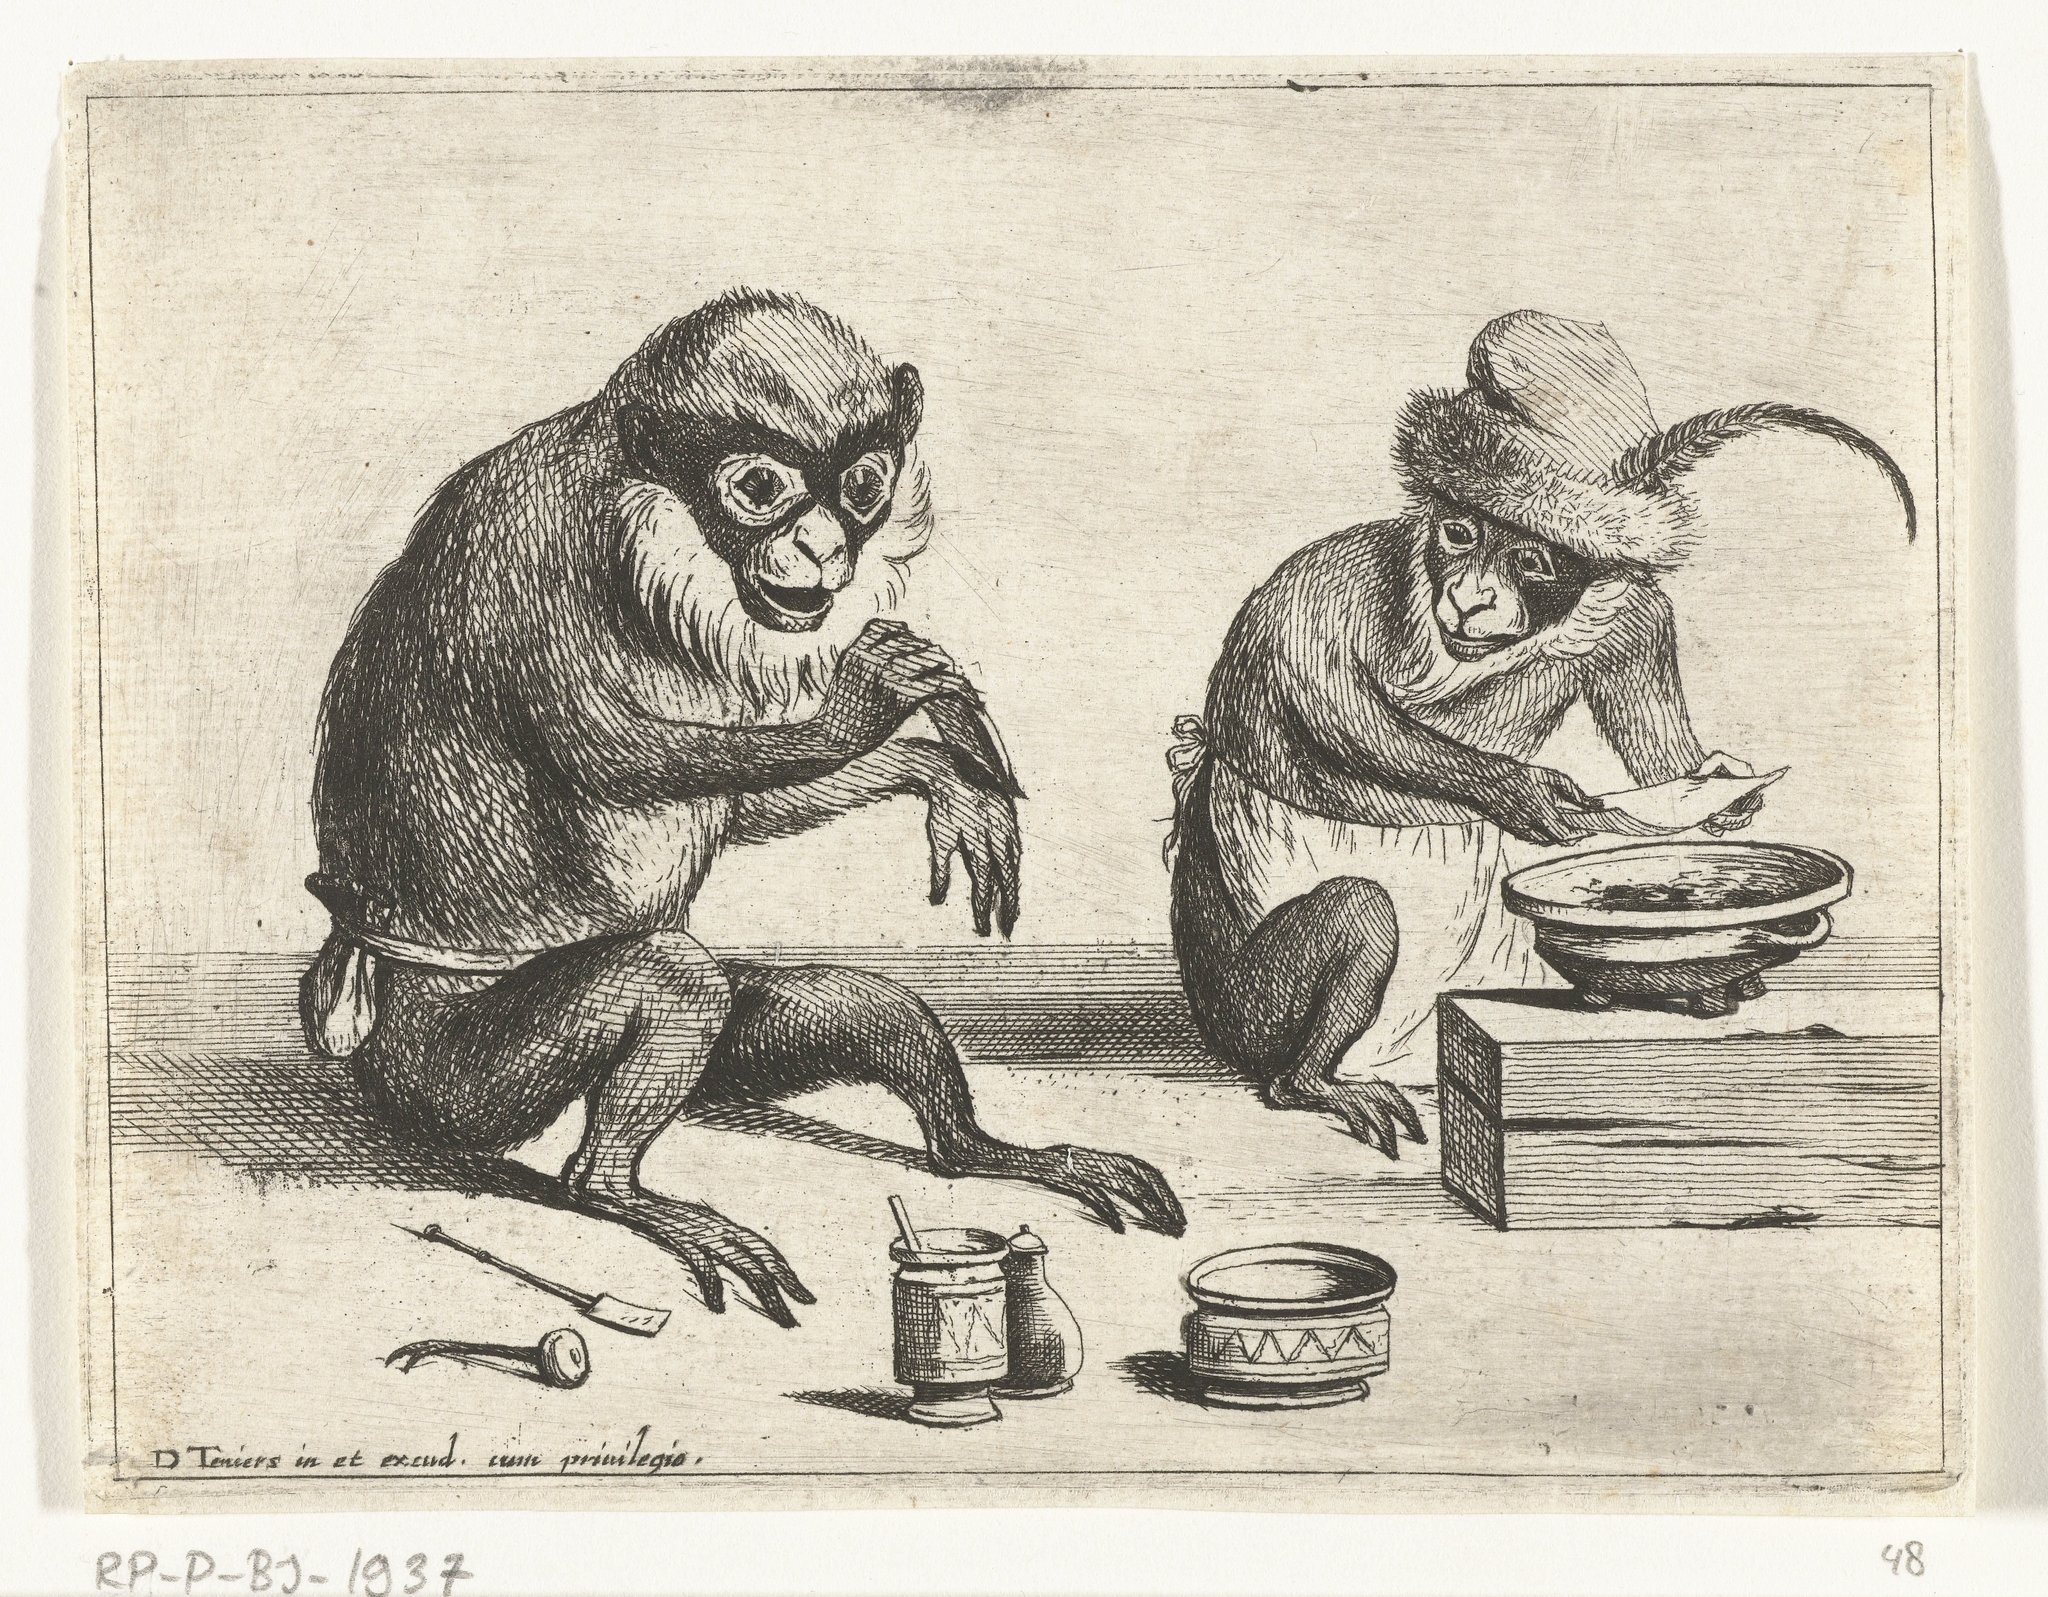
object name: print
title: het Apespel inde werelt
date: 1635-1690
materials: paper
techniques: etching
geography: southern netherlands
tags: animals acting as human beings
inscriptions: collector's mark: Lugt 240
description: Twee apen zitten op de grond, een aap verwarmt verbandmateriaal boven een vuurpot. De andere aap legt bij zichzelf een verband om zijn pols. Op de voorgrond staan potten met zalf. Prent uit een serie van zes prenten en een titelprent waarin verschillende menselijke bezigheden door apen voorgesteld worden.